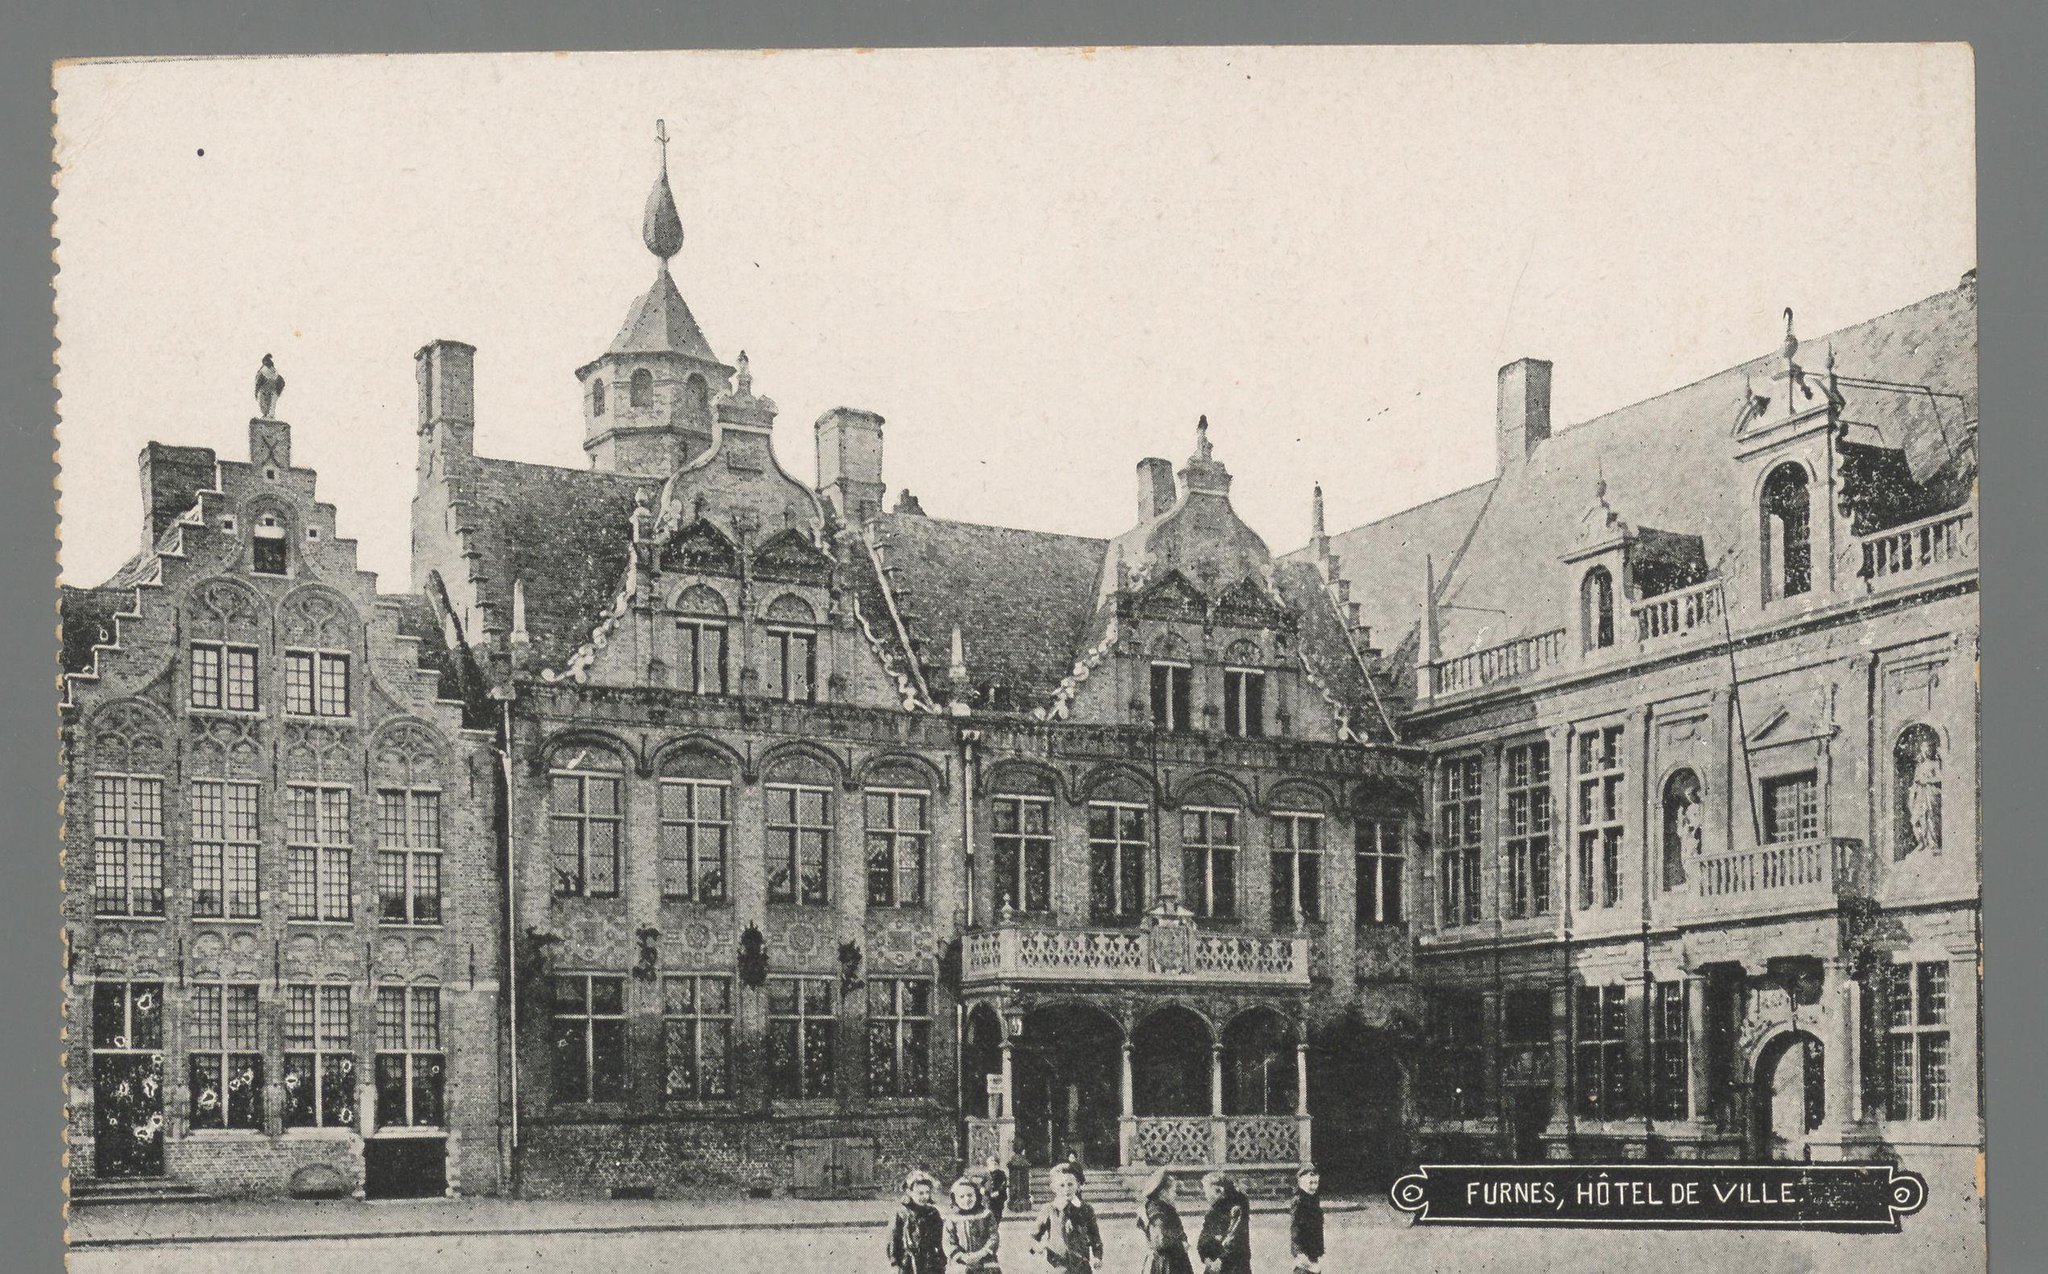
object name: ansichtkaart, prentbriefkaart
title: Furnes, hôtel de ville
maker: Anonymous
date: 1906-1918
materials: cardboard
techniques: autotype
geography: veurne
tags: townhall, city-view in general; 'veduta' (+ city(-scape) with figures, staffage)